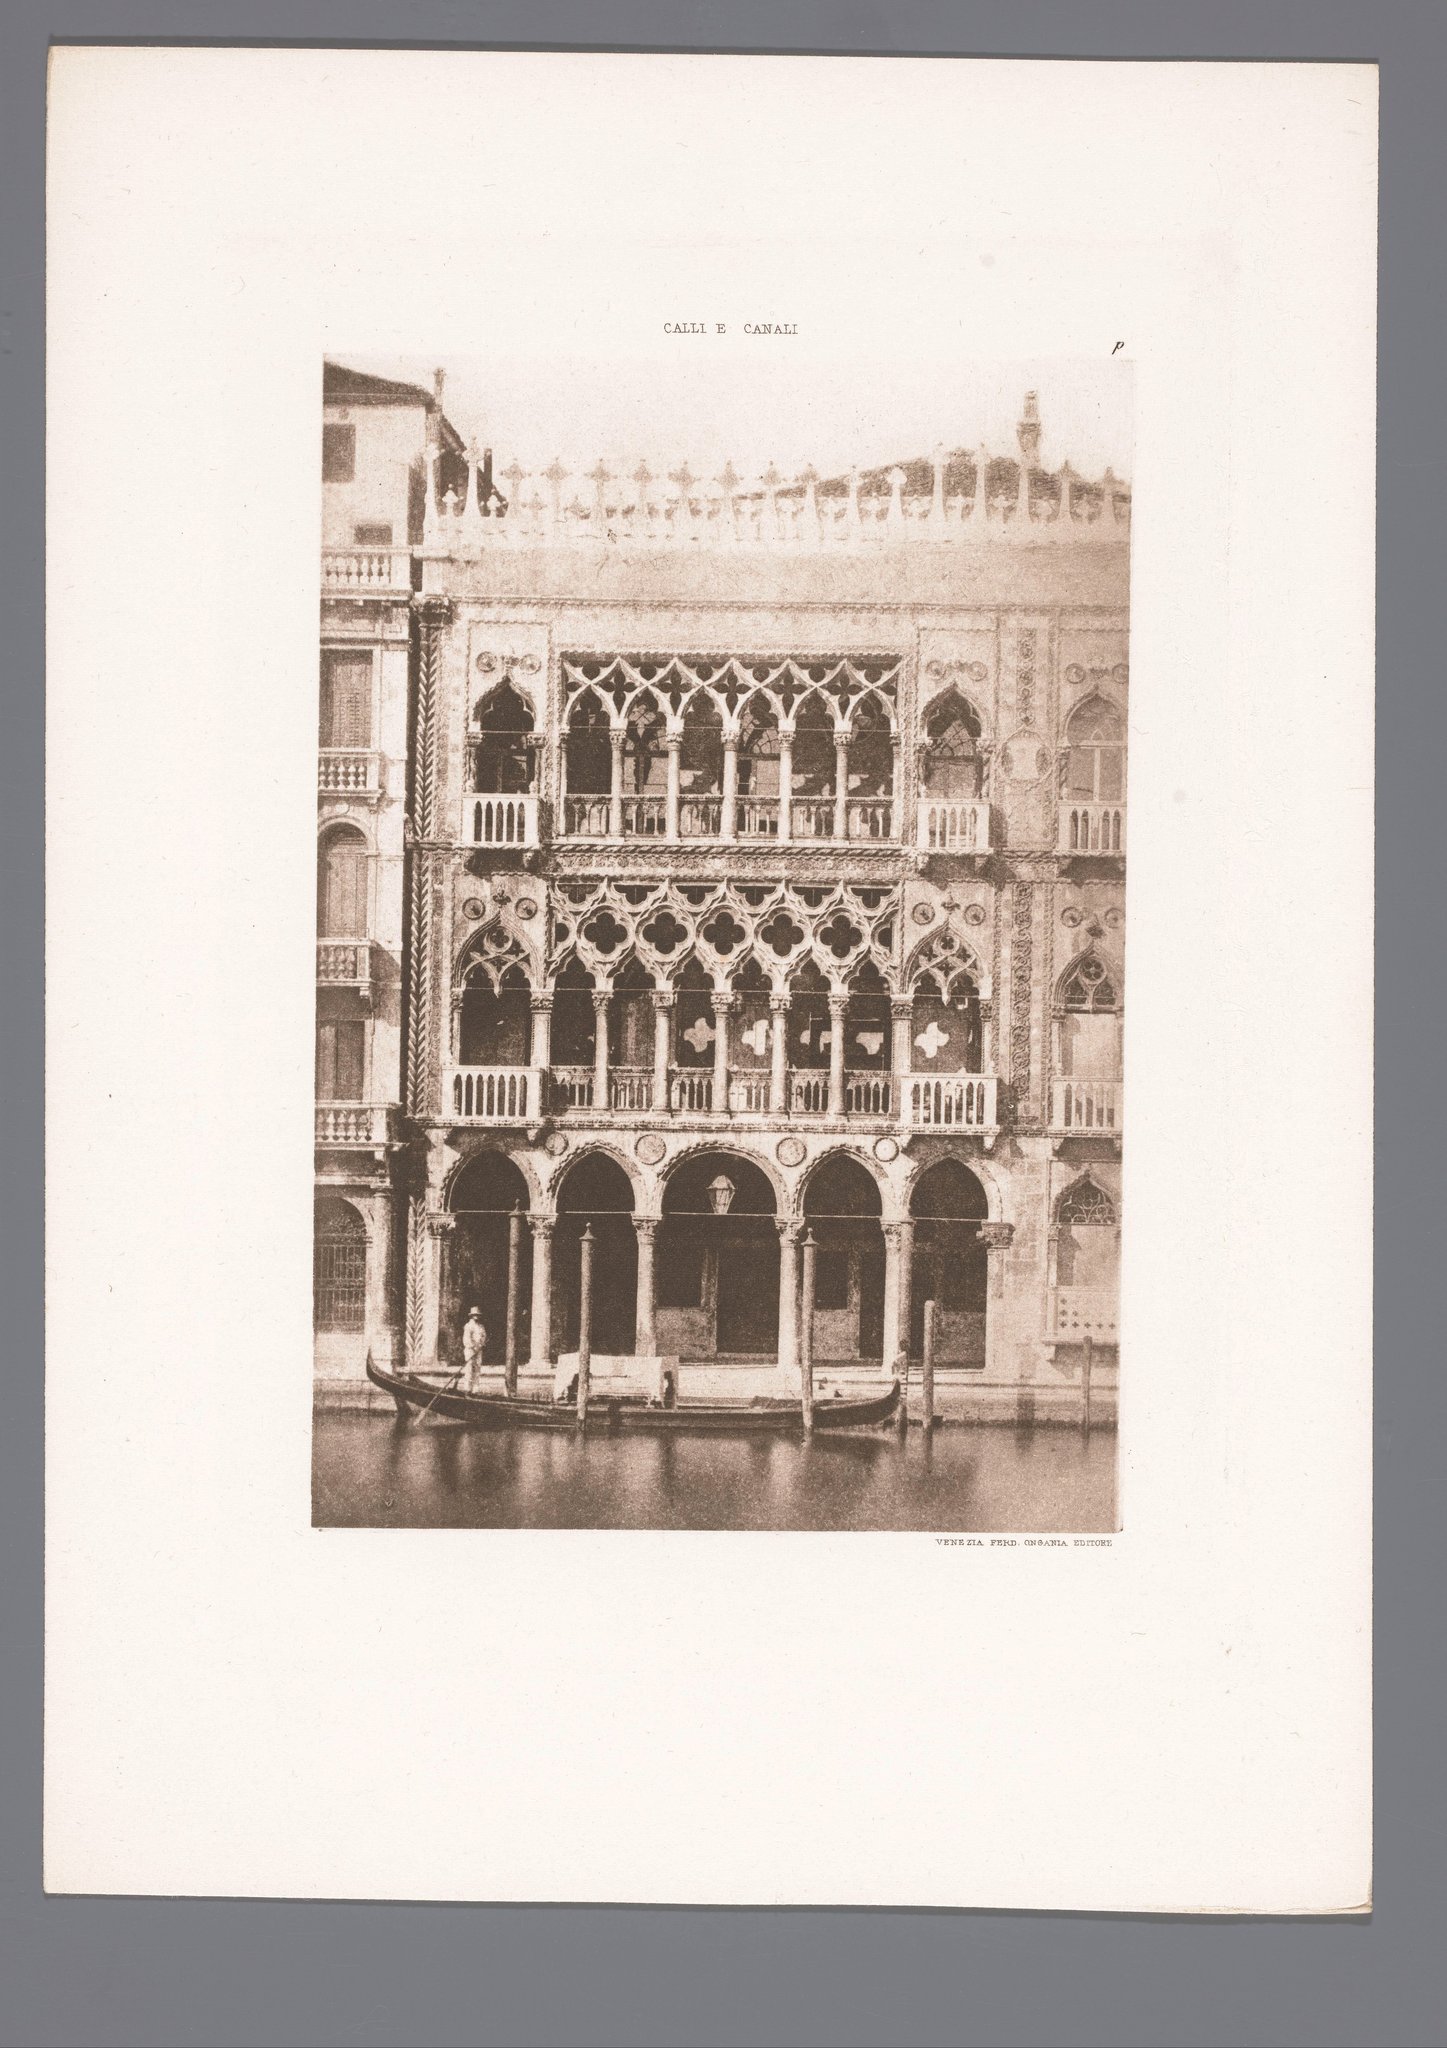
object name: photomechanical print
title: Gezicht op het Ca' d'Oro aan het Canal Grande in Venetië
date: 1888-1898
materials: paper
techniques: photoaquatint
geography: venice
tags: palace, canals, waters (in city)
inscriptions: inscription: ‘p’